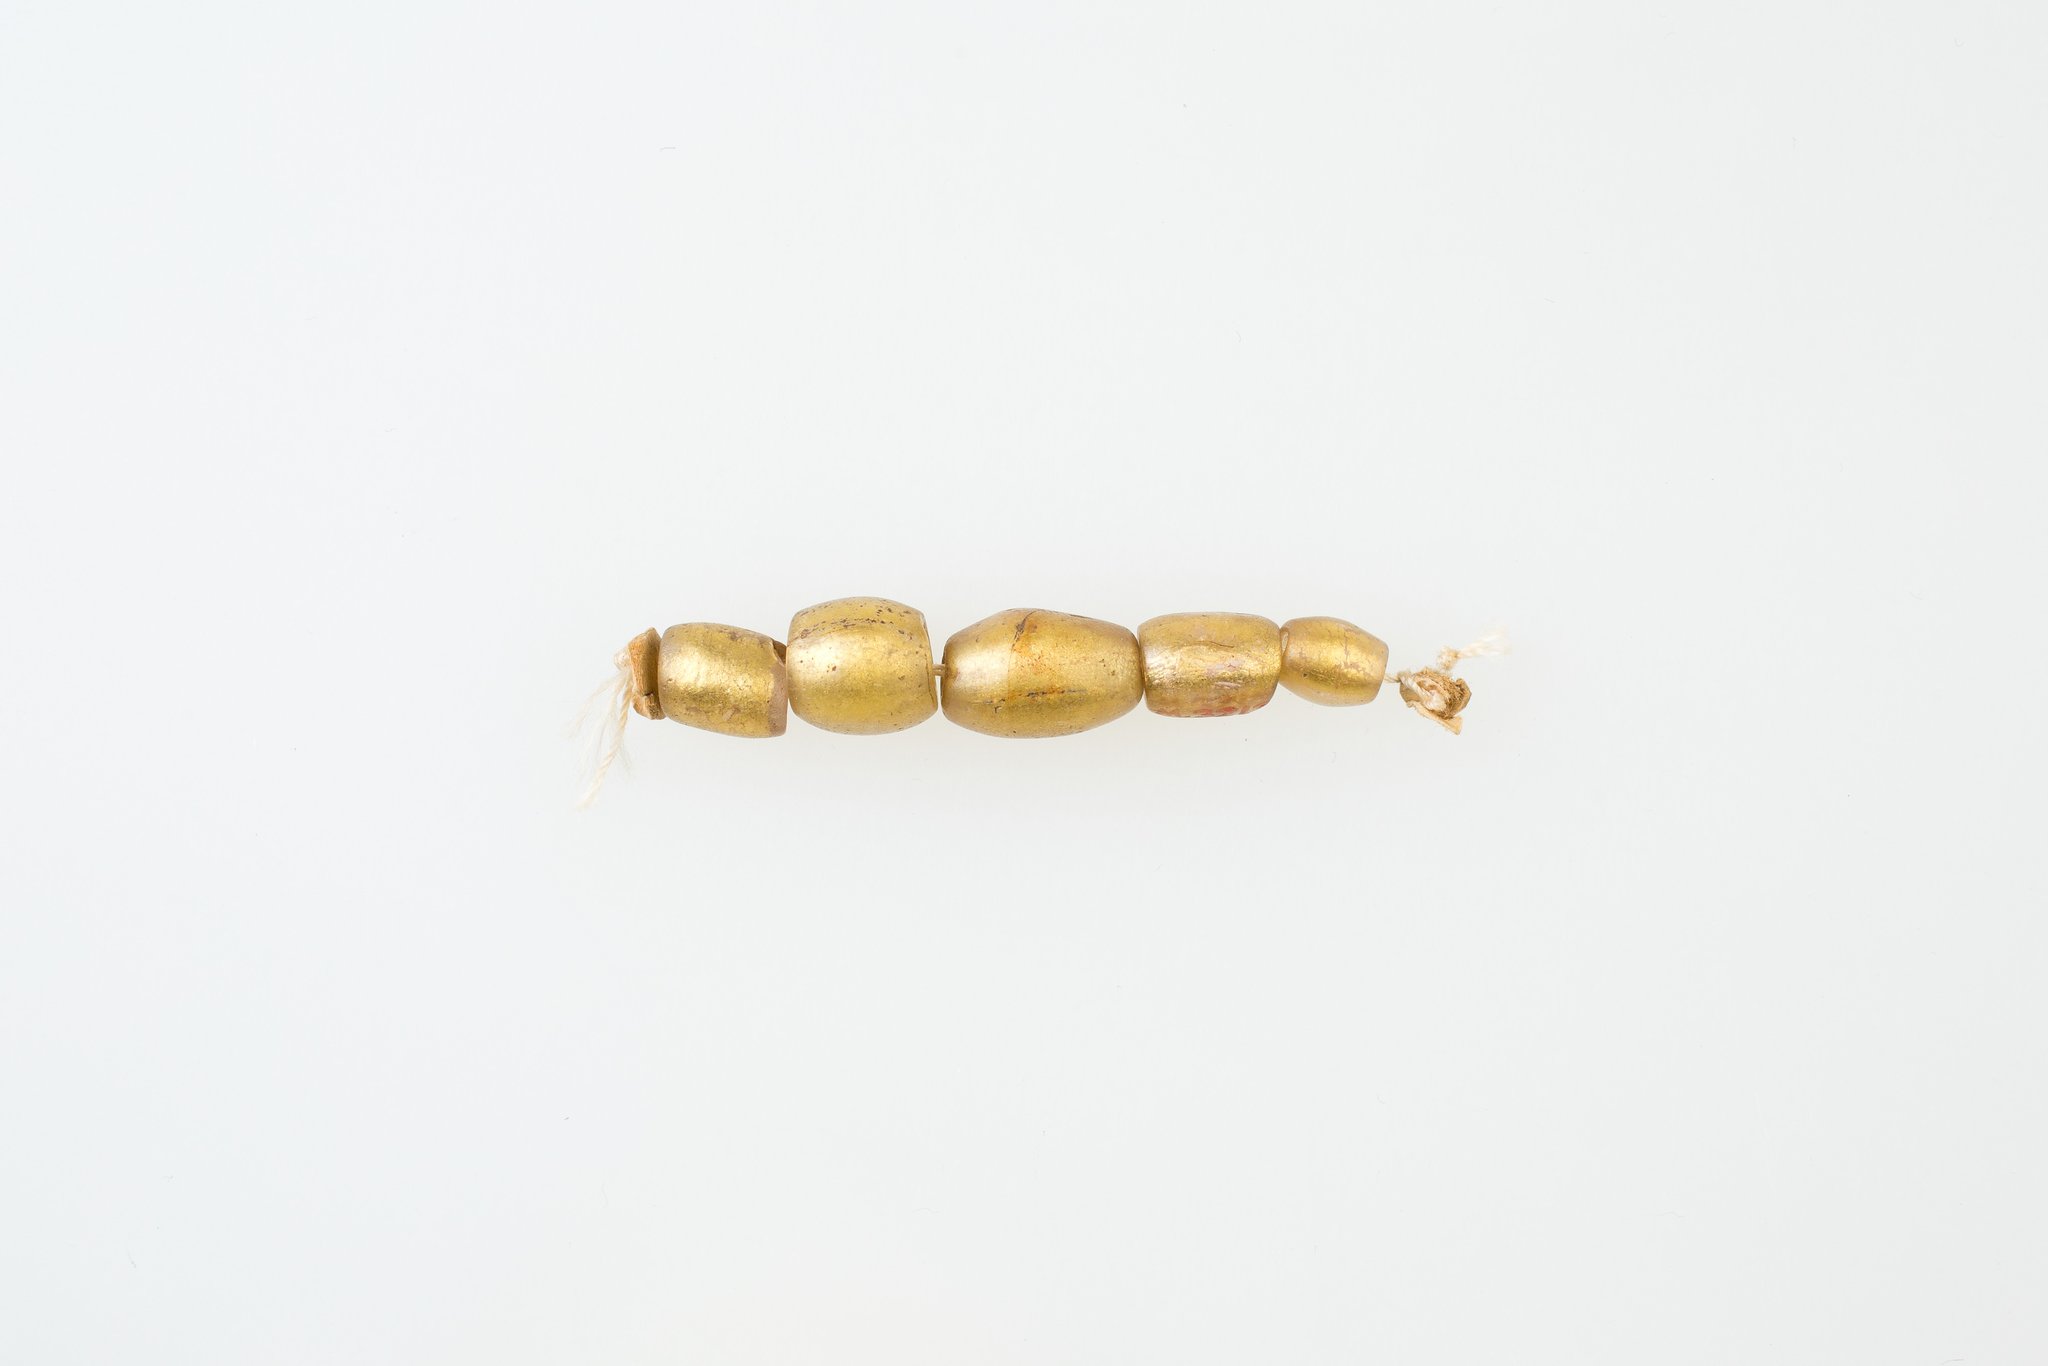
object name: bead, string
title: String of 5 Beads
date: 200 BCE-200 CE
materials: glass, gold foil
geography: egypt